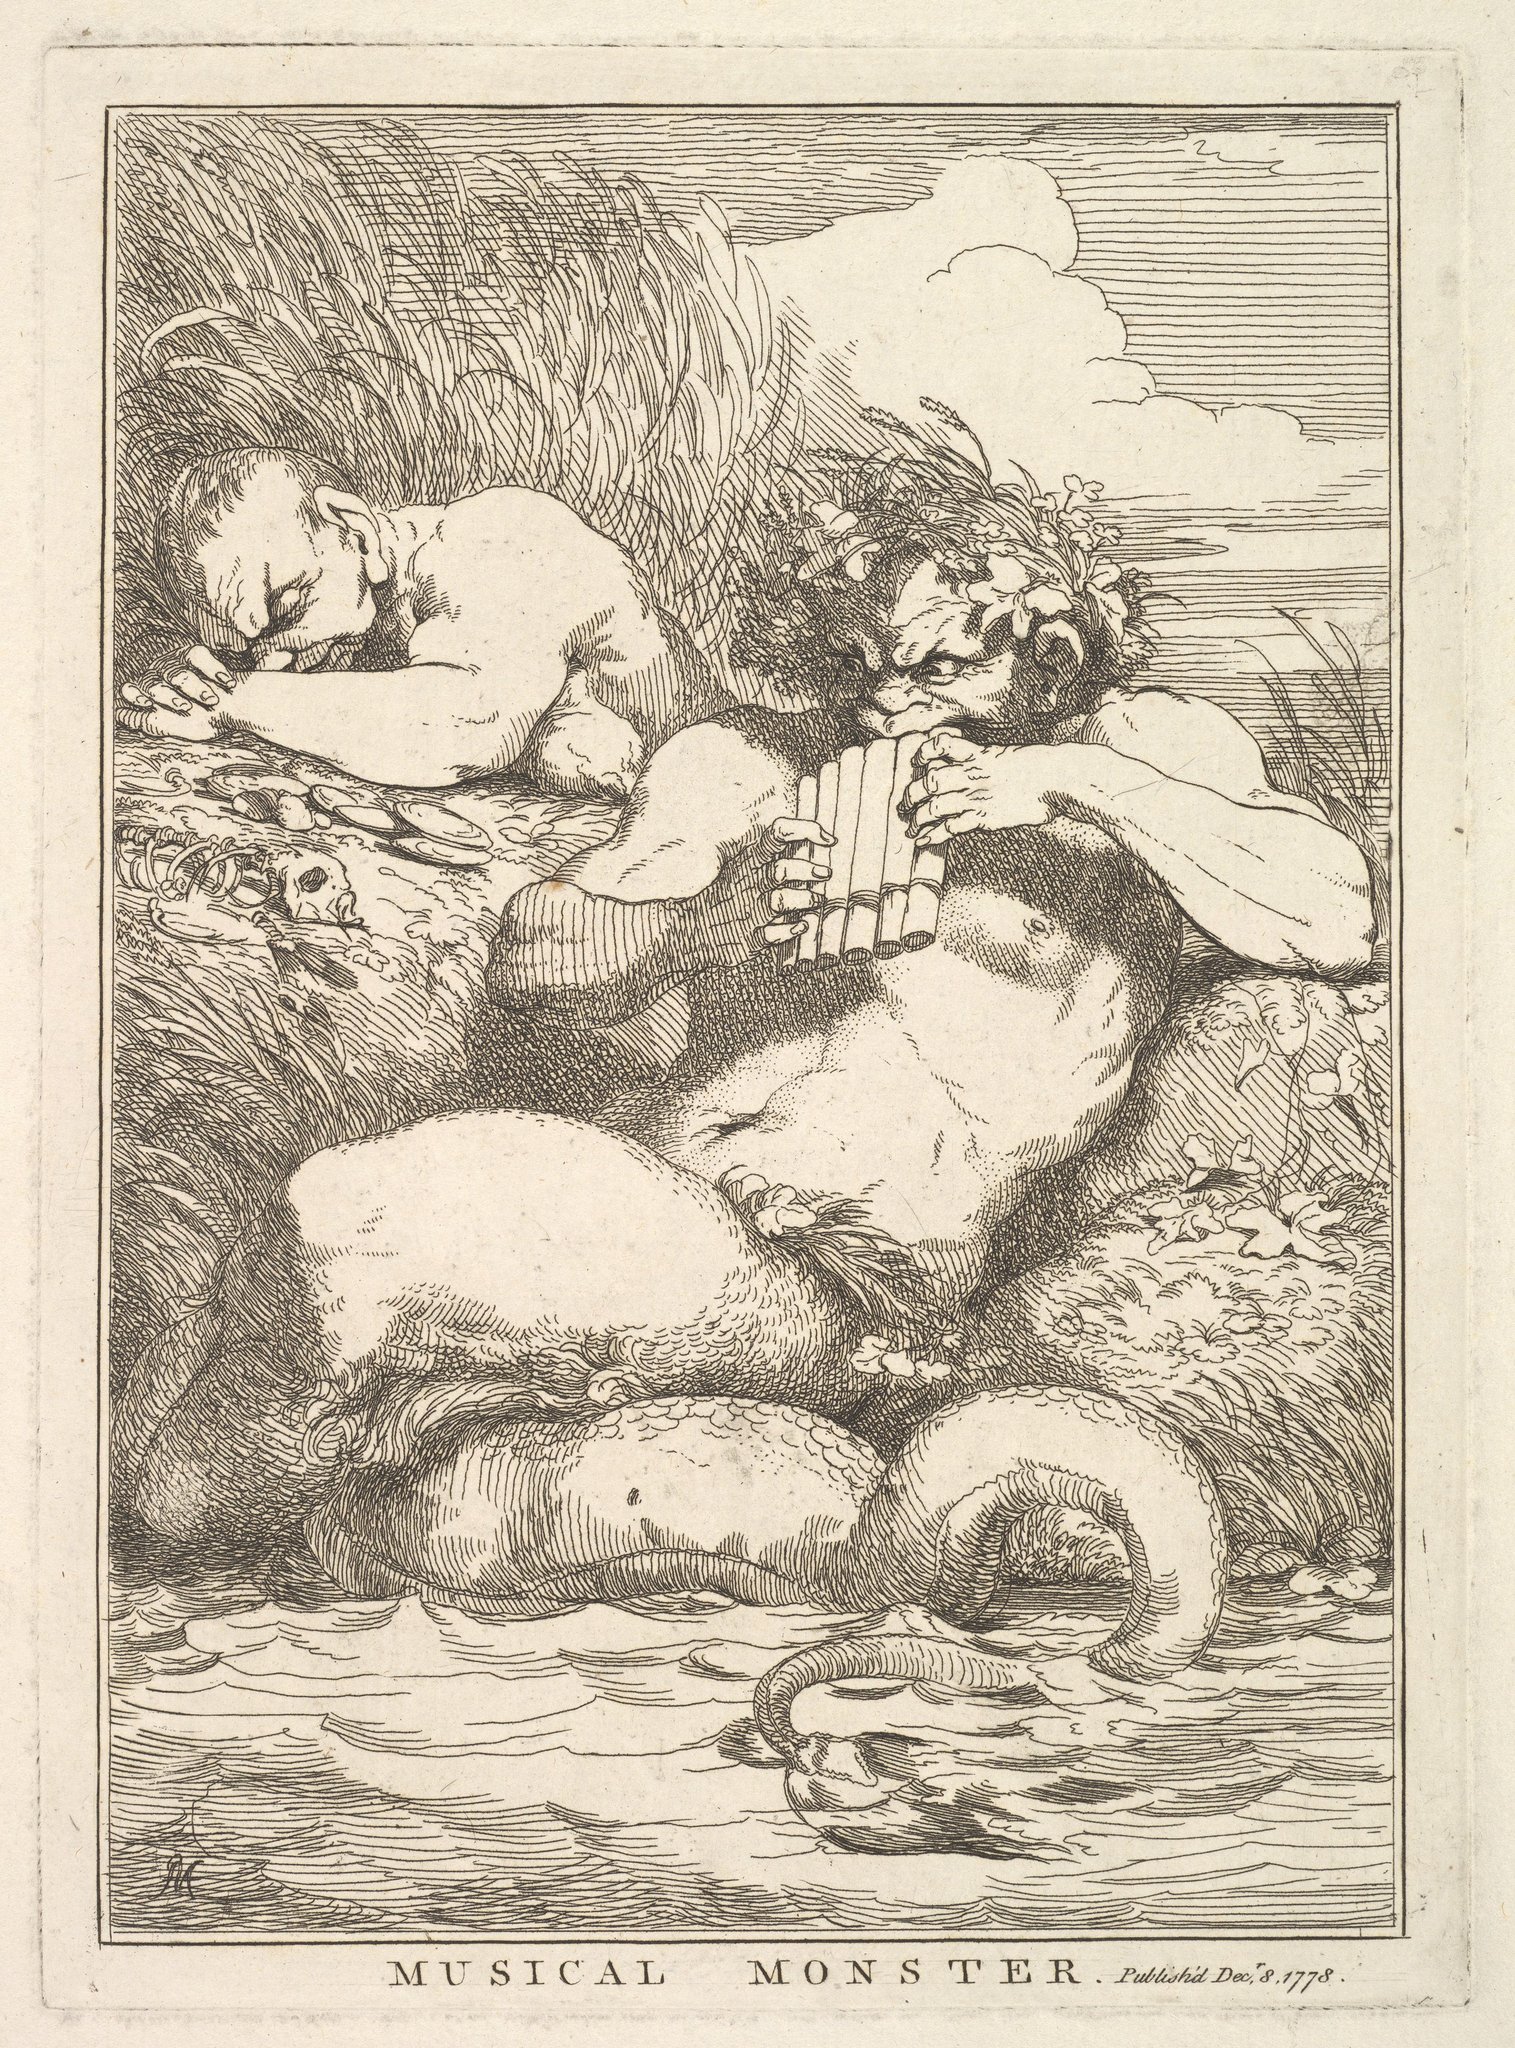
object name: print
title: Musical Monster, from "Fifteen Etchings Dedicated to Sir Joshua Reynolds"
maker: john hamilton mortimer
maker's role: artist and publisher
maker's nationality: british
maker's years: 1740-1779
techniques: etching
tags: musical instruments,monsters